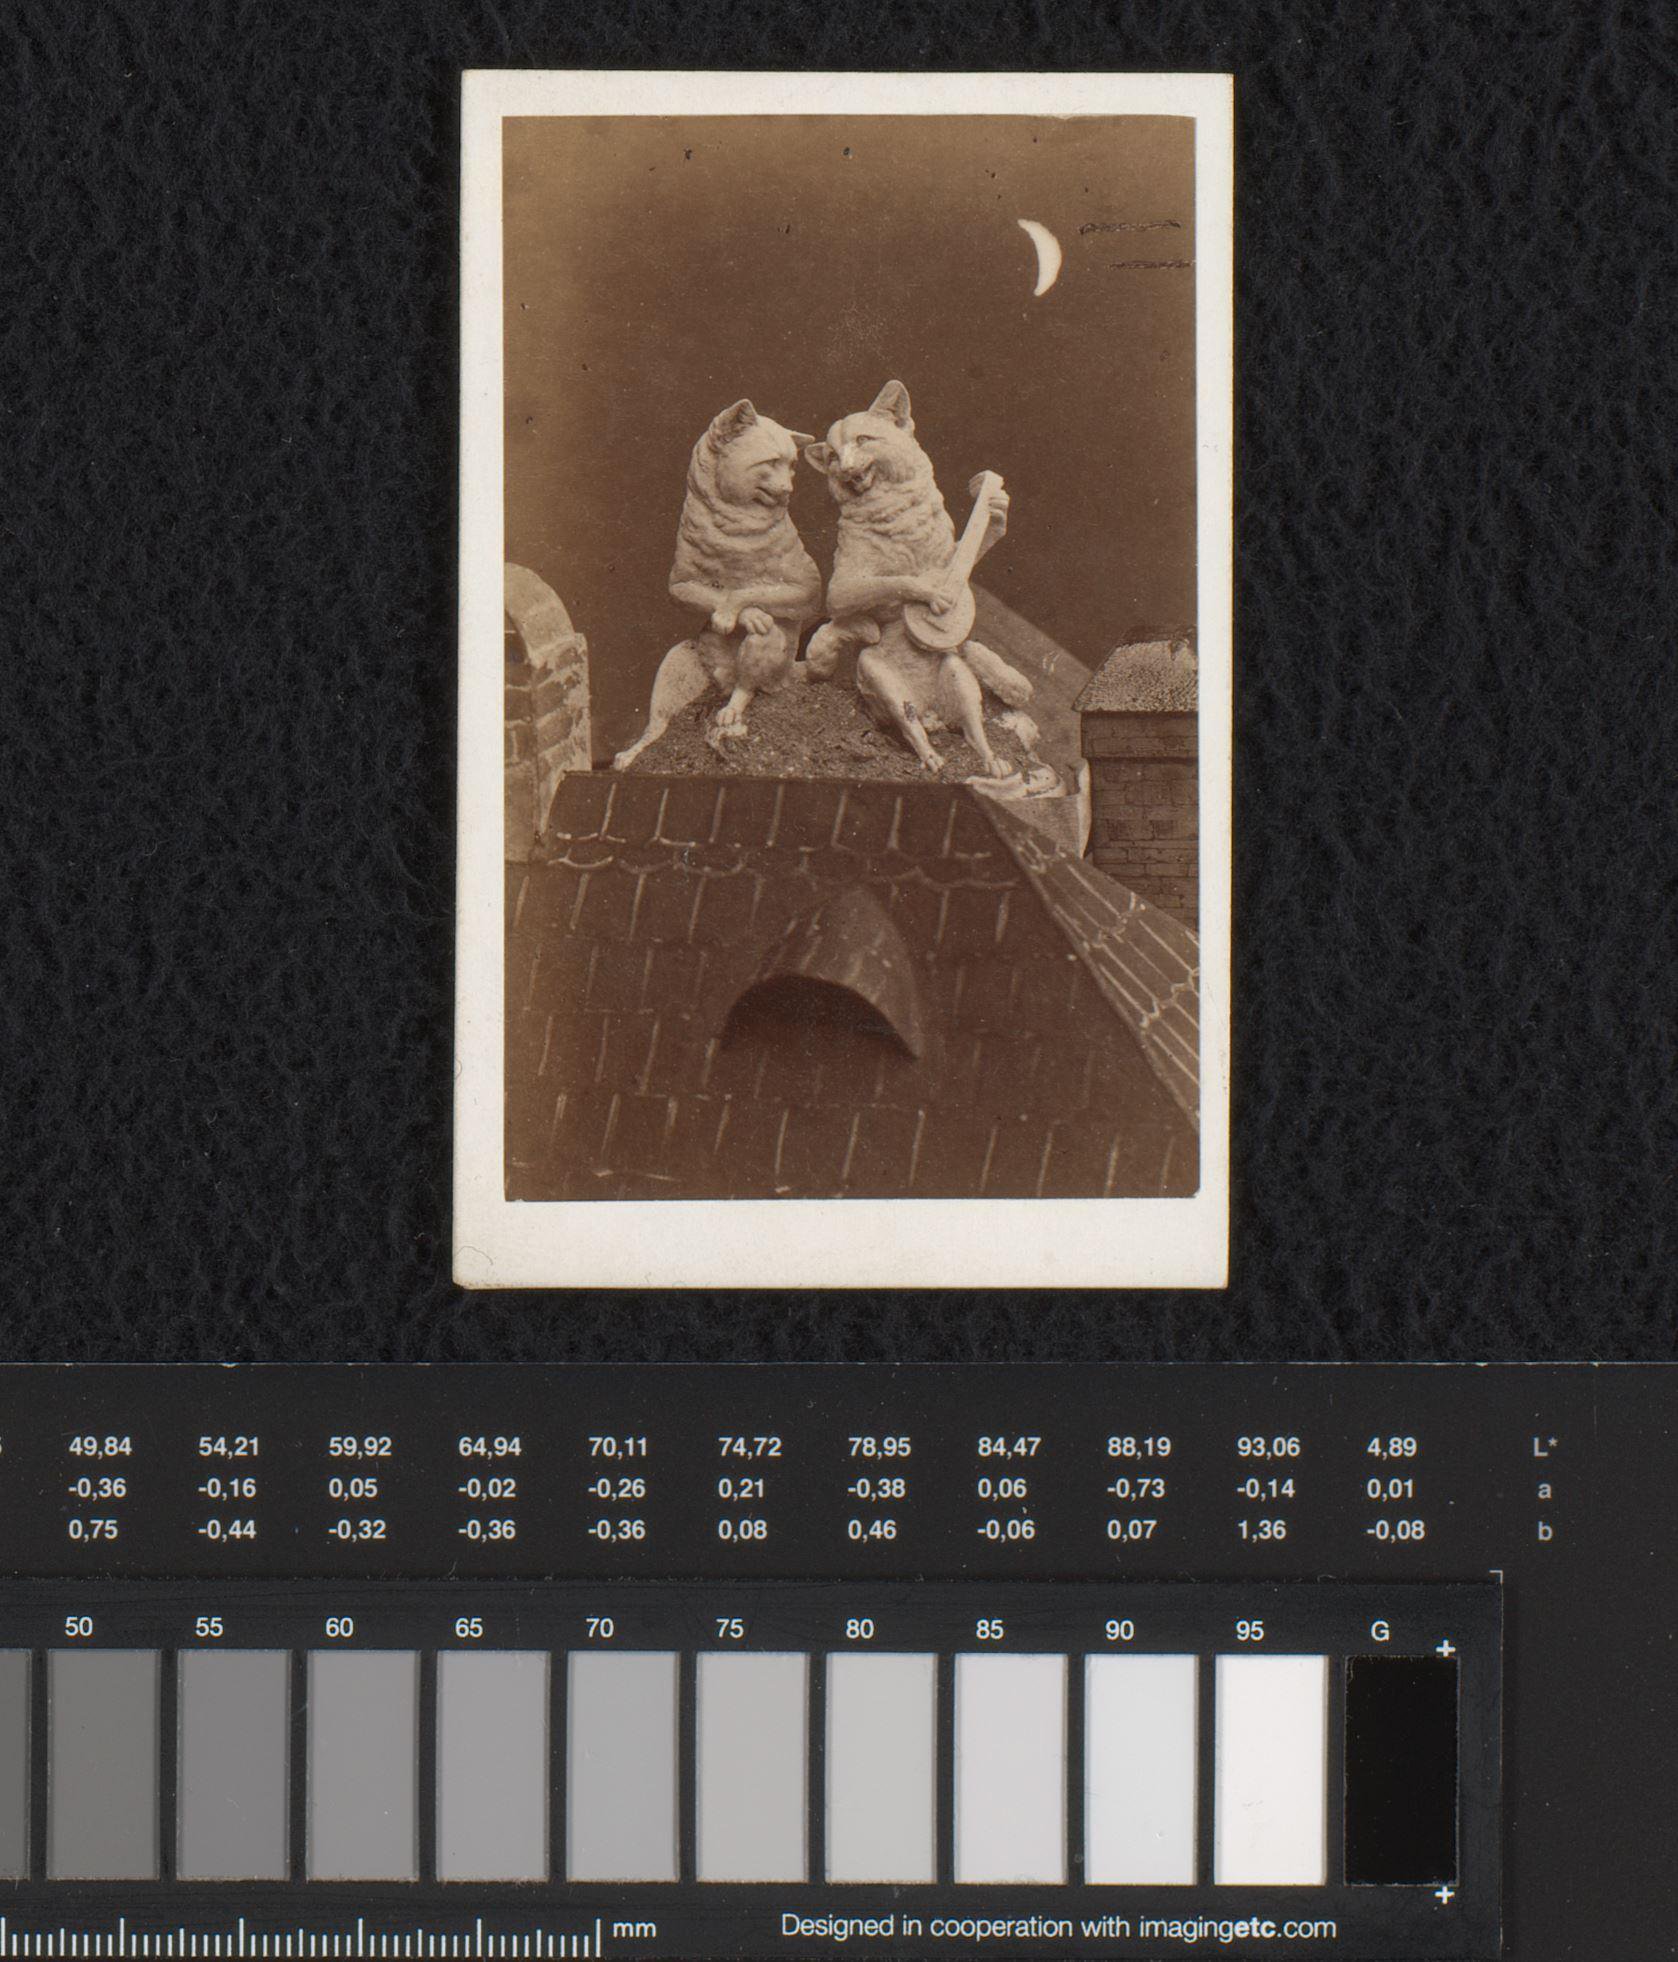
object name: album leaf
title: Sculptuur van twee wolven met een gitaar op een dak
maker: Anonymous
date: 1870-1890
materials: cardboard, photographic support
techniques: albumen print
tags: sculpture, cithern, mandolin, guitar, balalaika, beasts of prey, predatory animals: wolf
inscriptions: annotation: ‘Mijn heer zit op zijn uiterste gemak/ In de goot tegen een hellend tak/ Alwaar mijnheer/ Natuurlijk op berouw wacht, dit ook/ (...)’